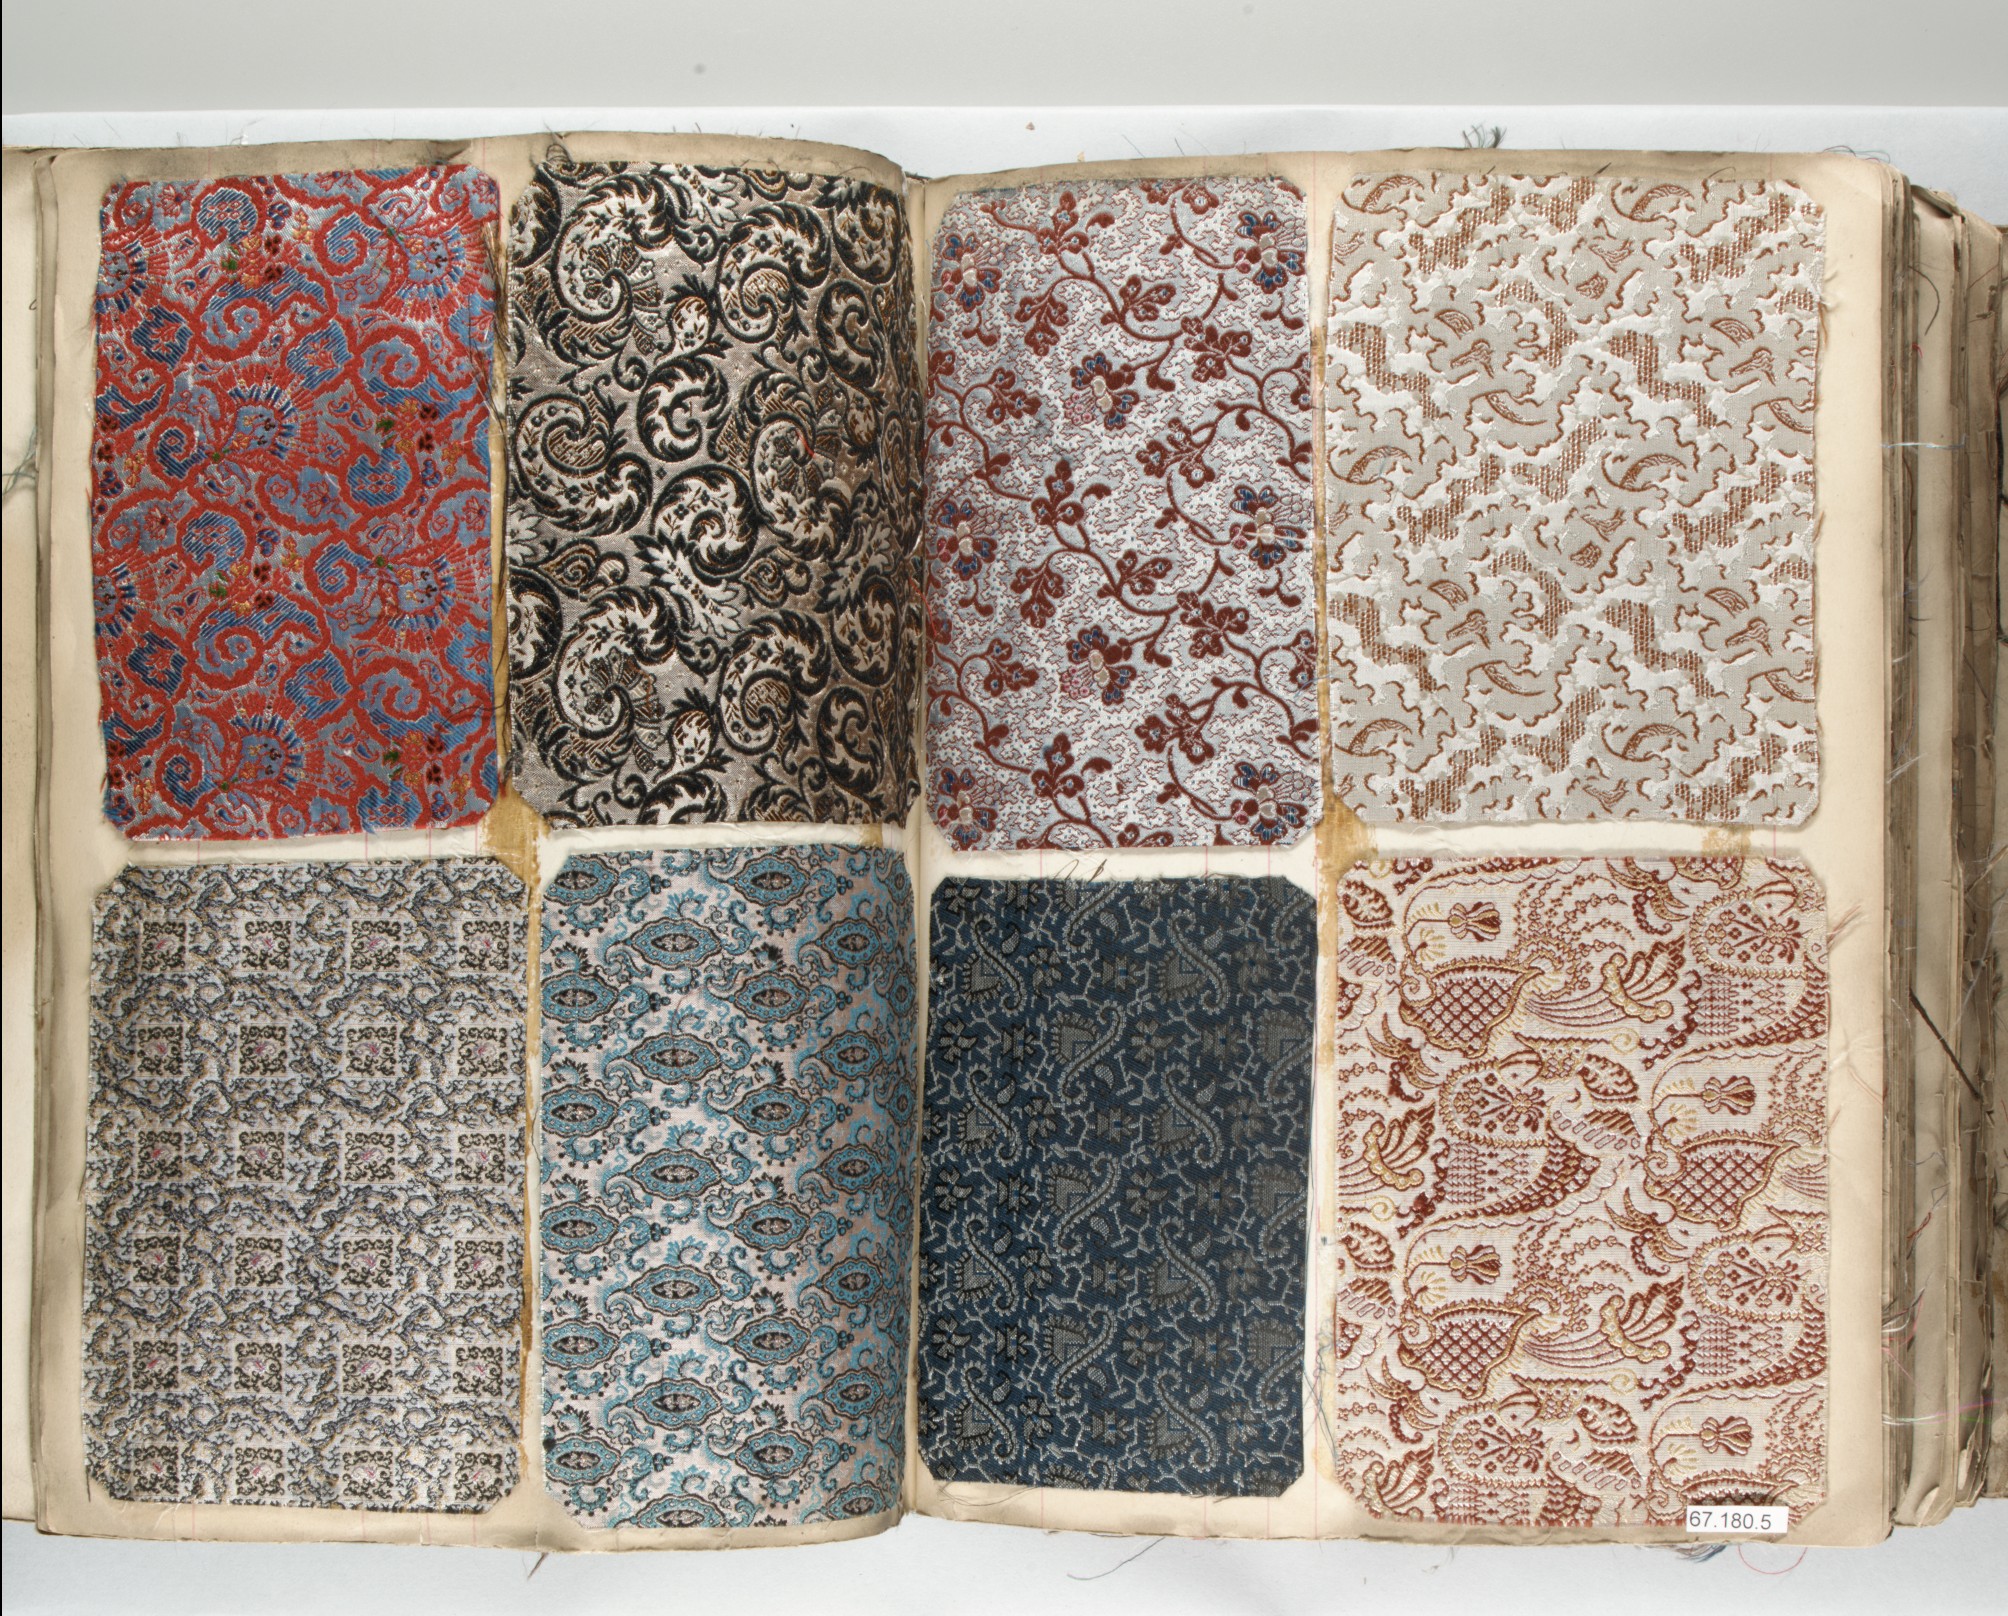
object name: sample book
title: Textile Sample Book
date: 1840-1850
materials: paper, silk, wool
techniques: weave